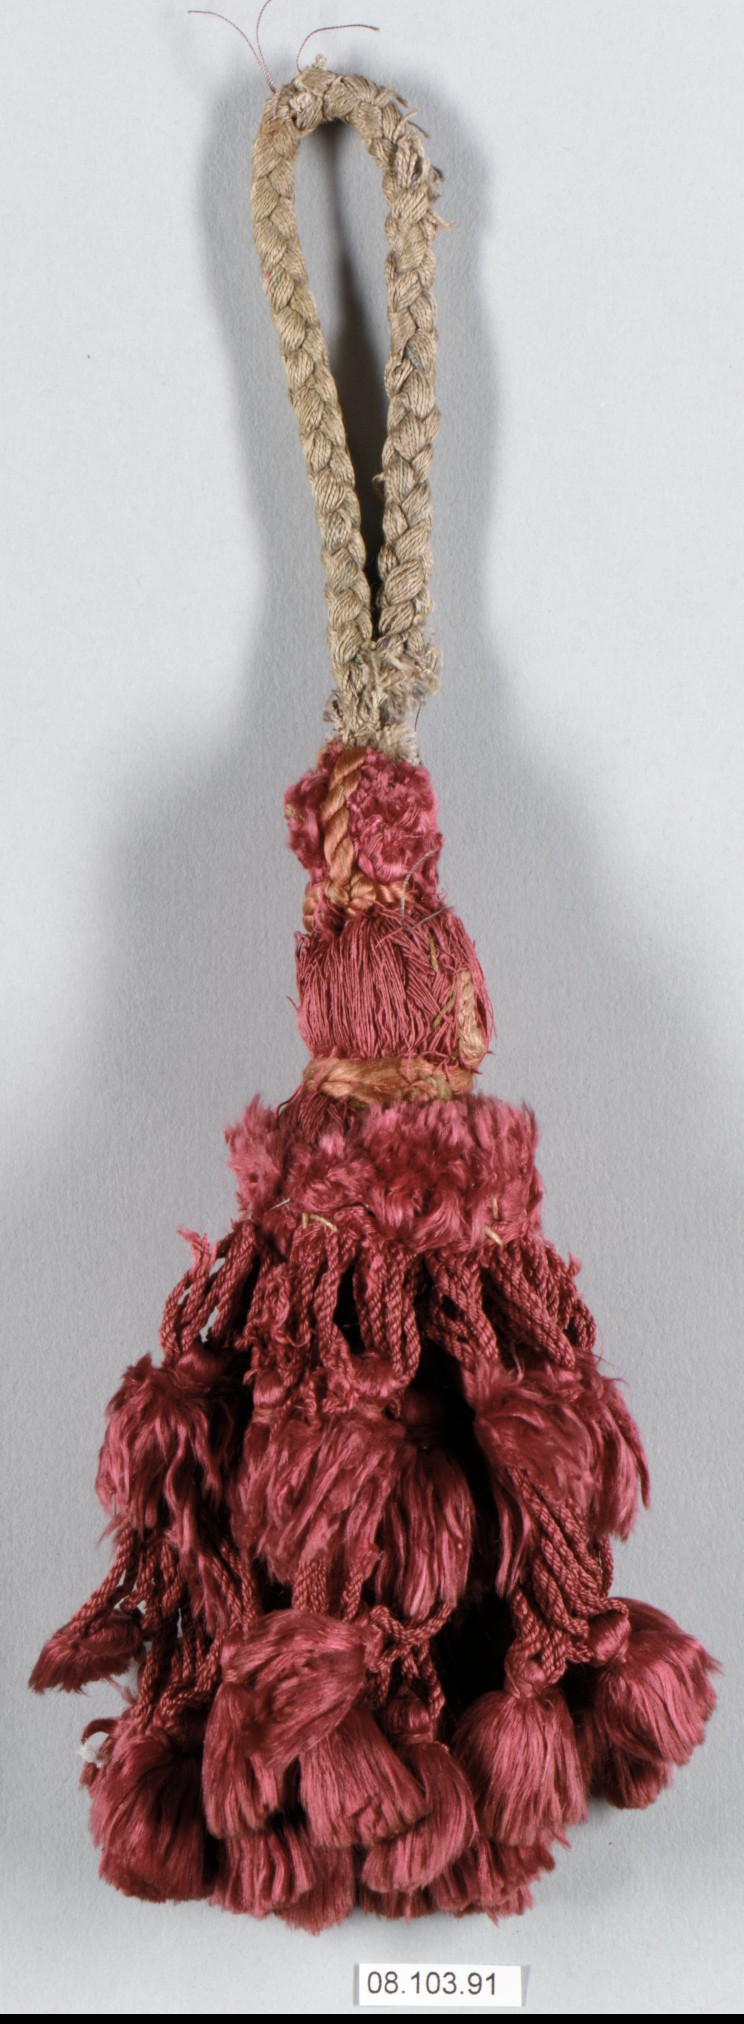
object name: tassel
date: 1567-1633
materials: silk